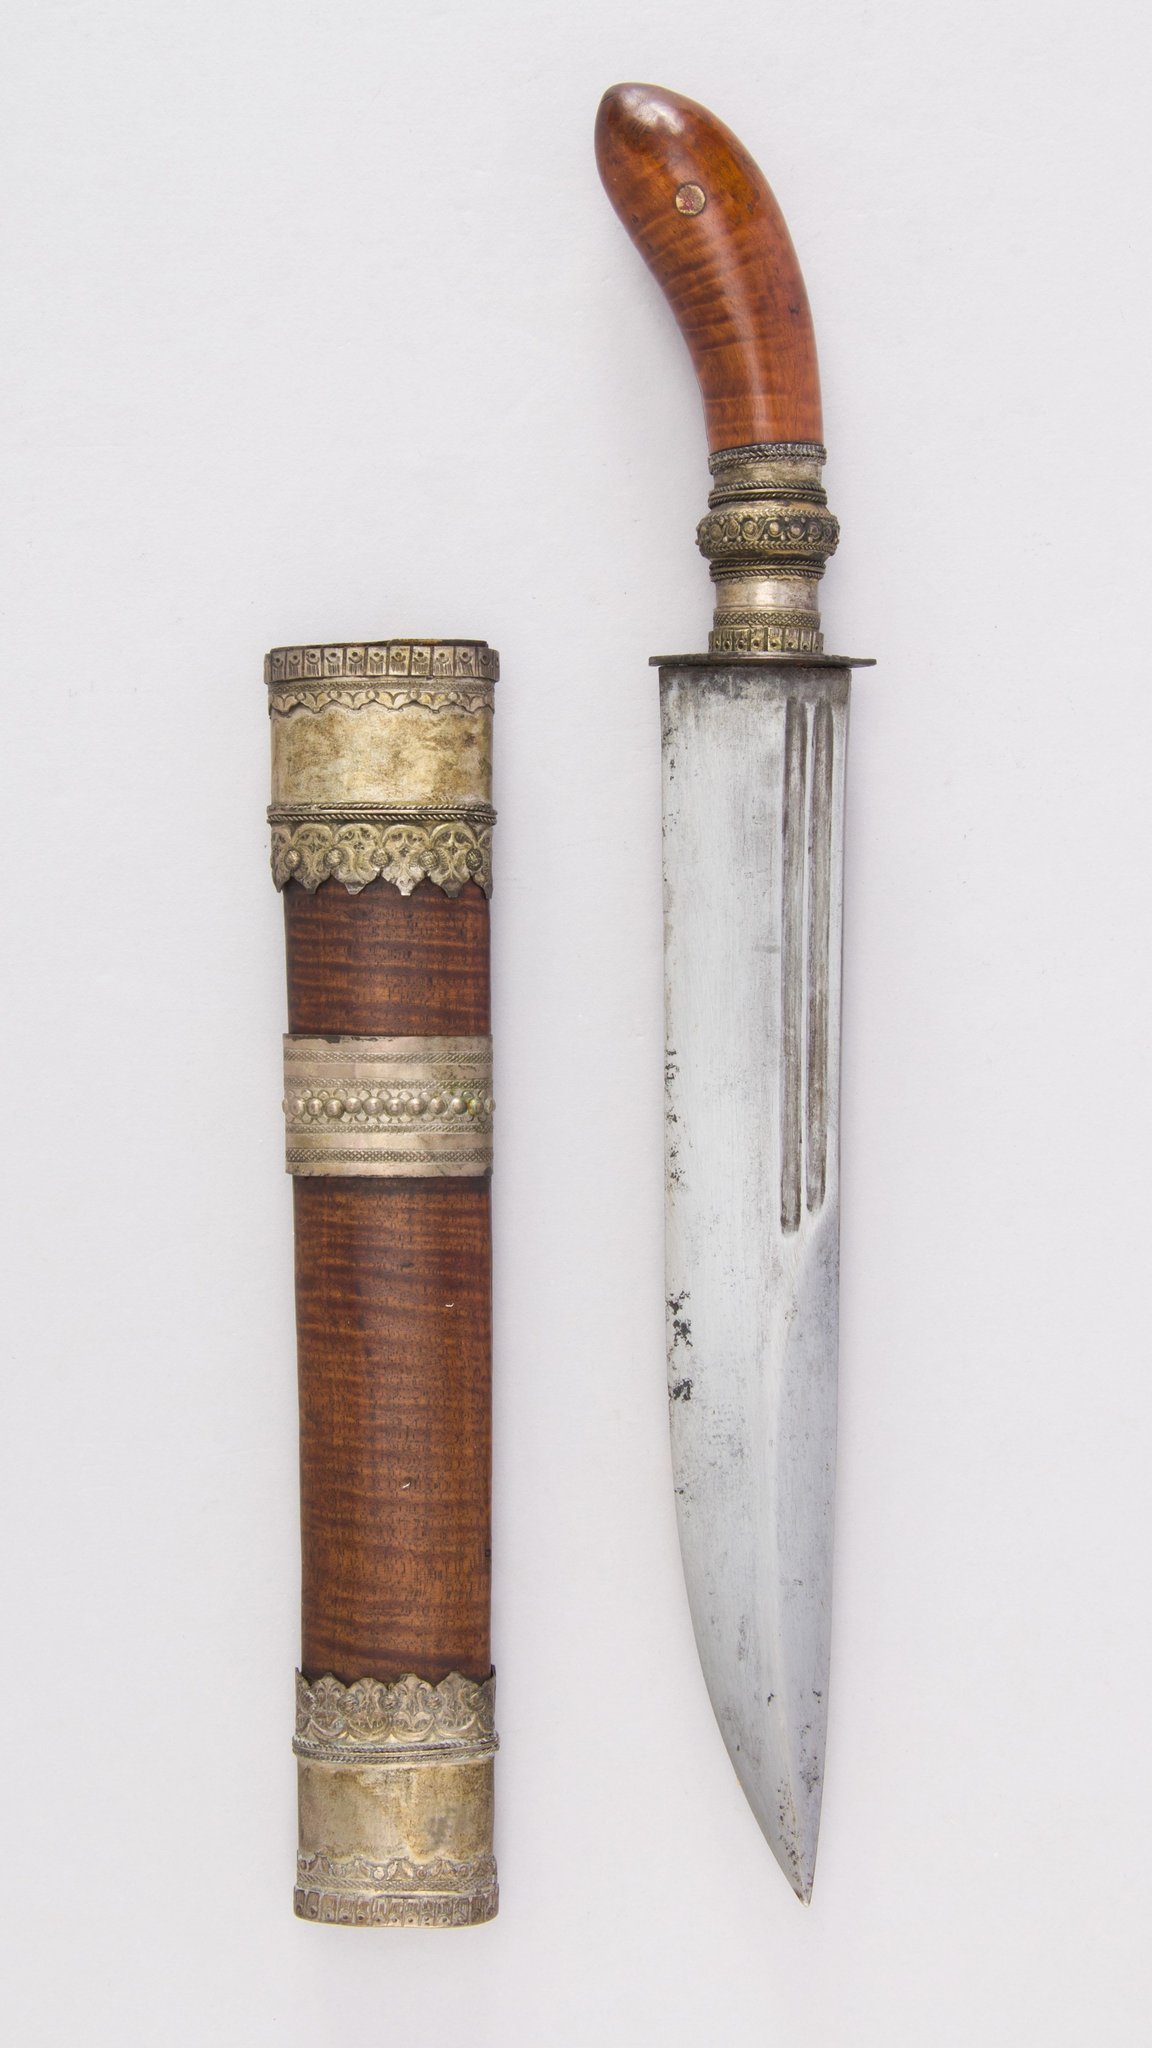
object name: knife with sheath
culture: philippine, moro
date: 1801-1900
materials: copper, silver, steel, wood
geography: philippines